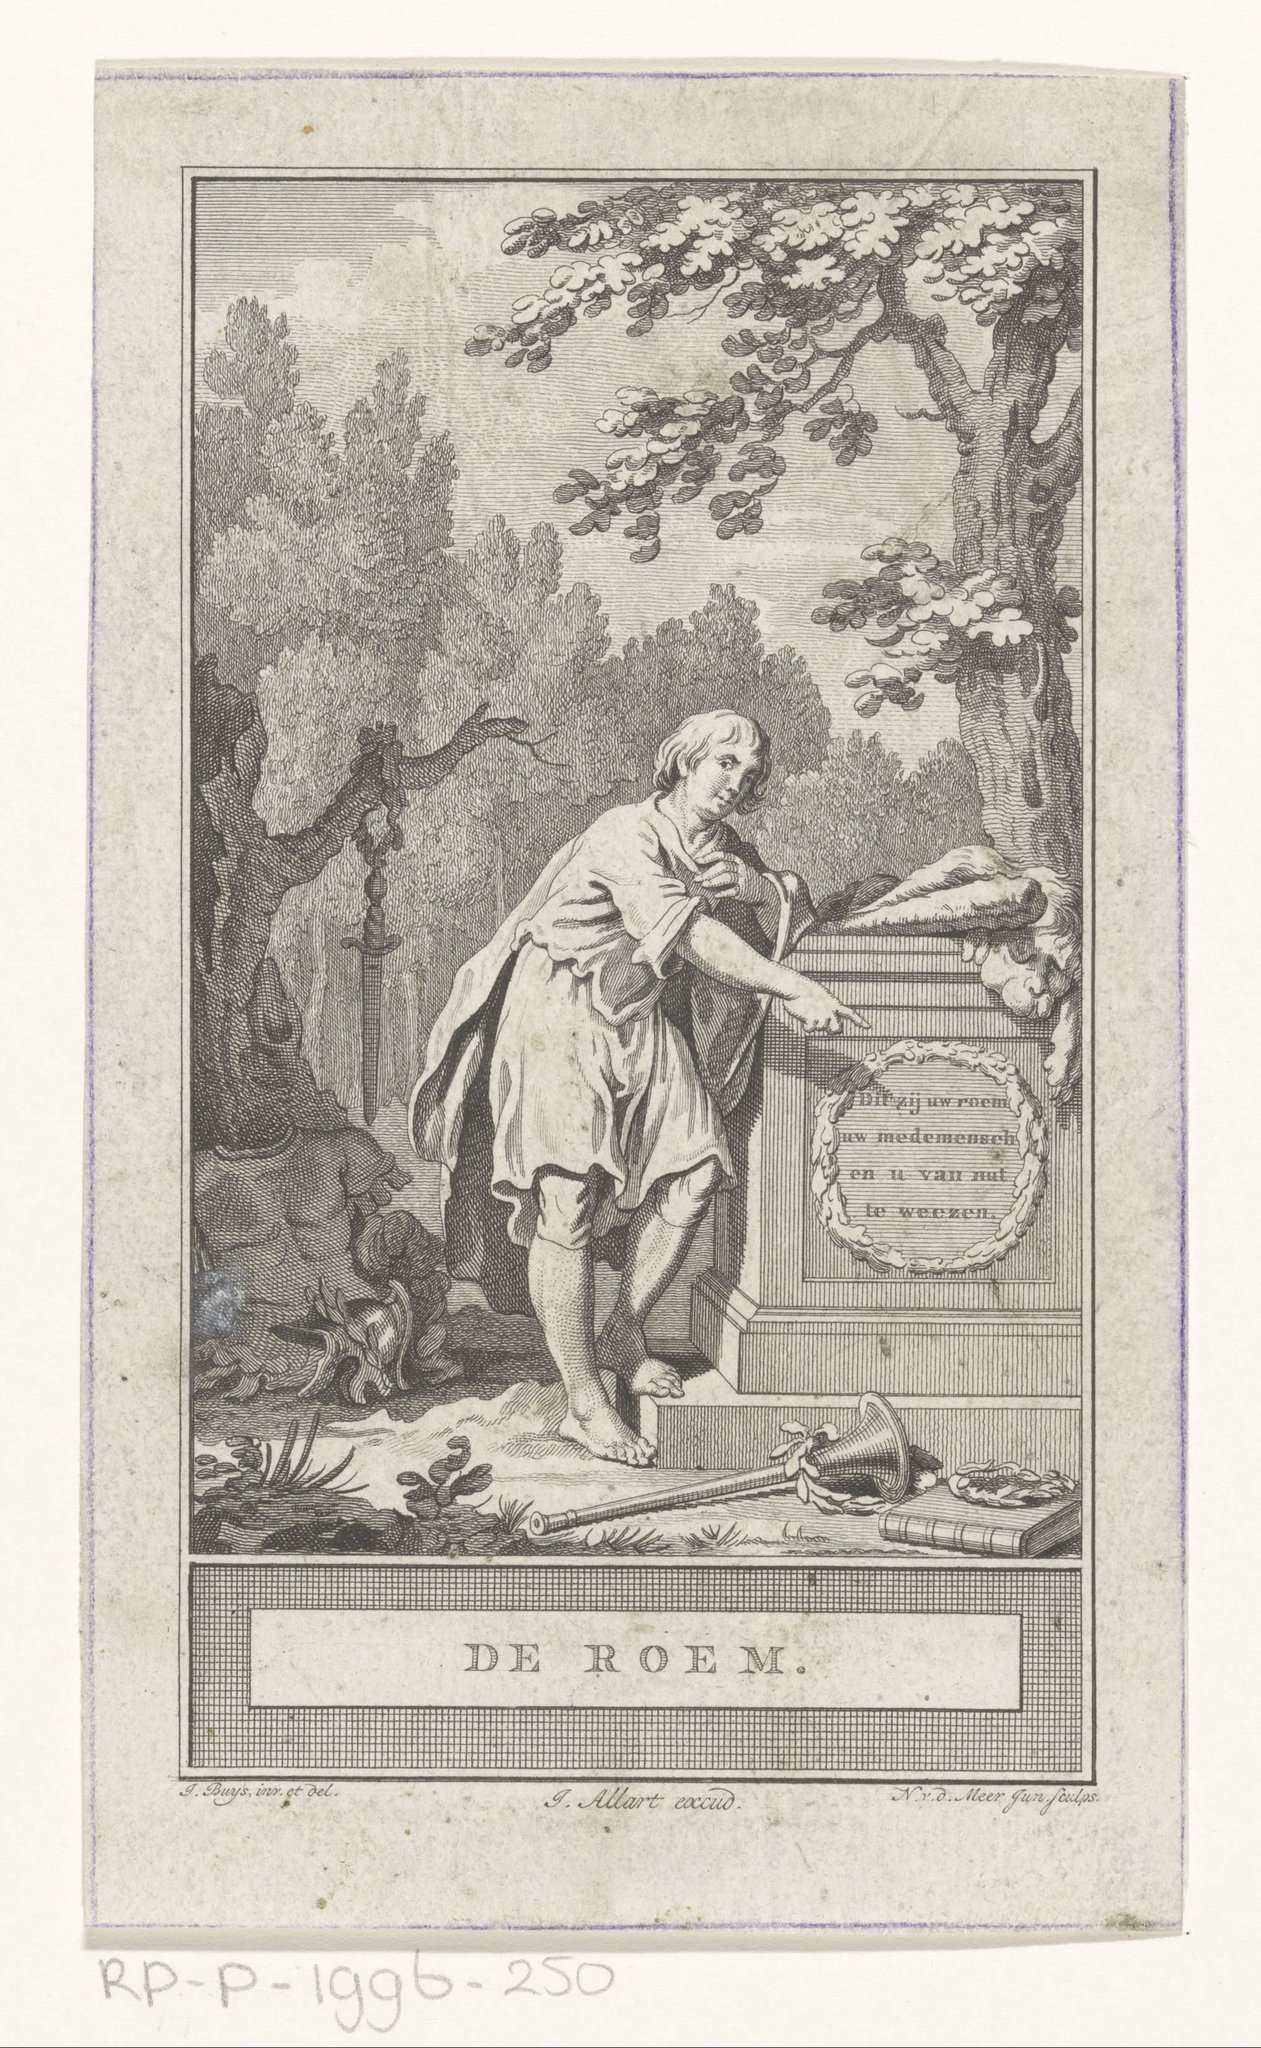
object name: book illustration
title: Roem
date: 1778-1785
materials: paper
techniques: etching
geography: amsterdam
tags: attributes of hercules, crowning with laurel, fame; 'fama', 'fama buona', 'fama chiara' (ripa)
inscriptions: collector's mark: Lugt 2228, collector's mark: Lugt 2760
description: Prent bij: Gellert, Christian Fürchtegott. Fabelen en vertelsels. 3 dln. Amsterdam: Pieter Meyer, 1772-1774. De prenten bij deze publicatie werden later uitgegeven. De exemplaren uitgegeven door de weduwe Jacobus Loveringh & Johannes Allart tussen 1777 en 1778, de exemplaren uitgegeven door alleen Johannes Allart tussen 1778 en 1785.